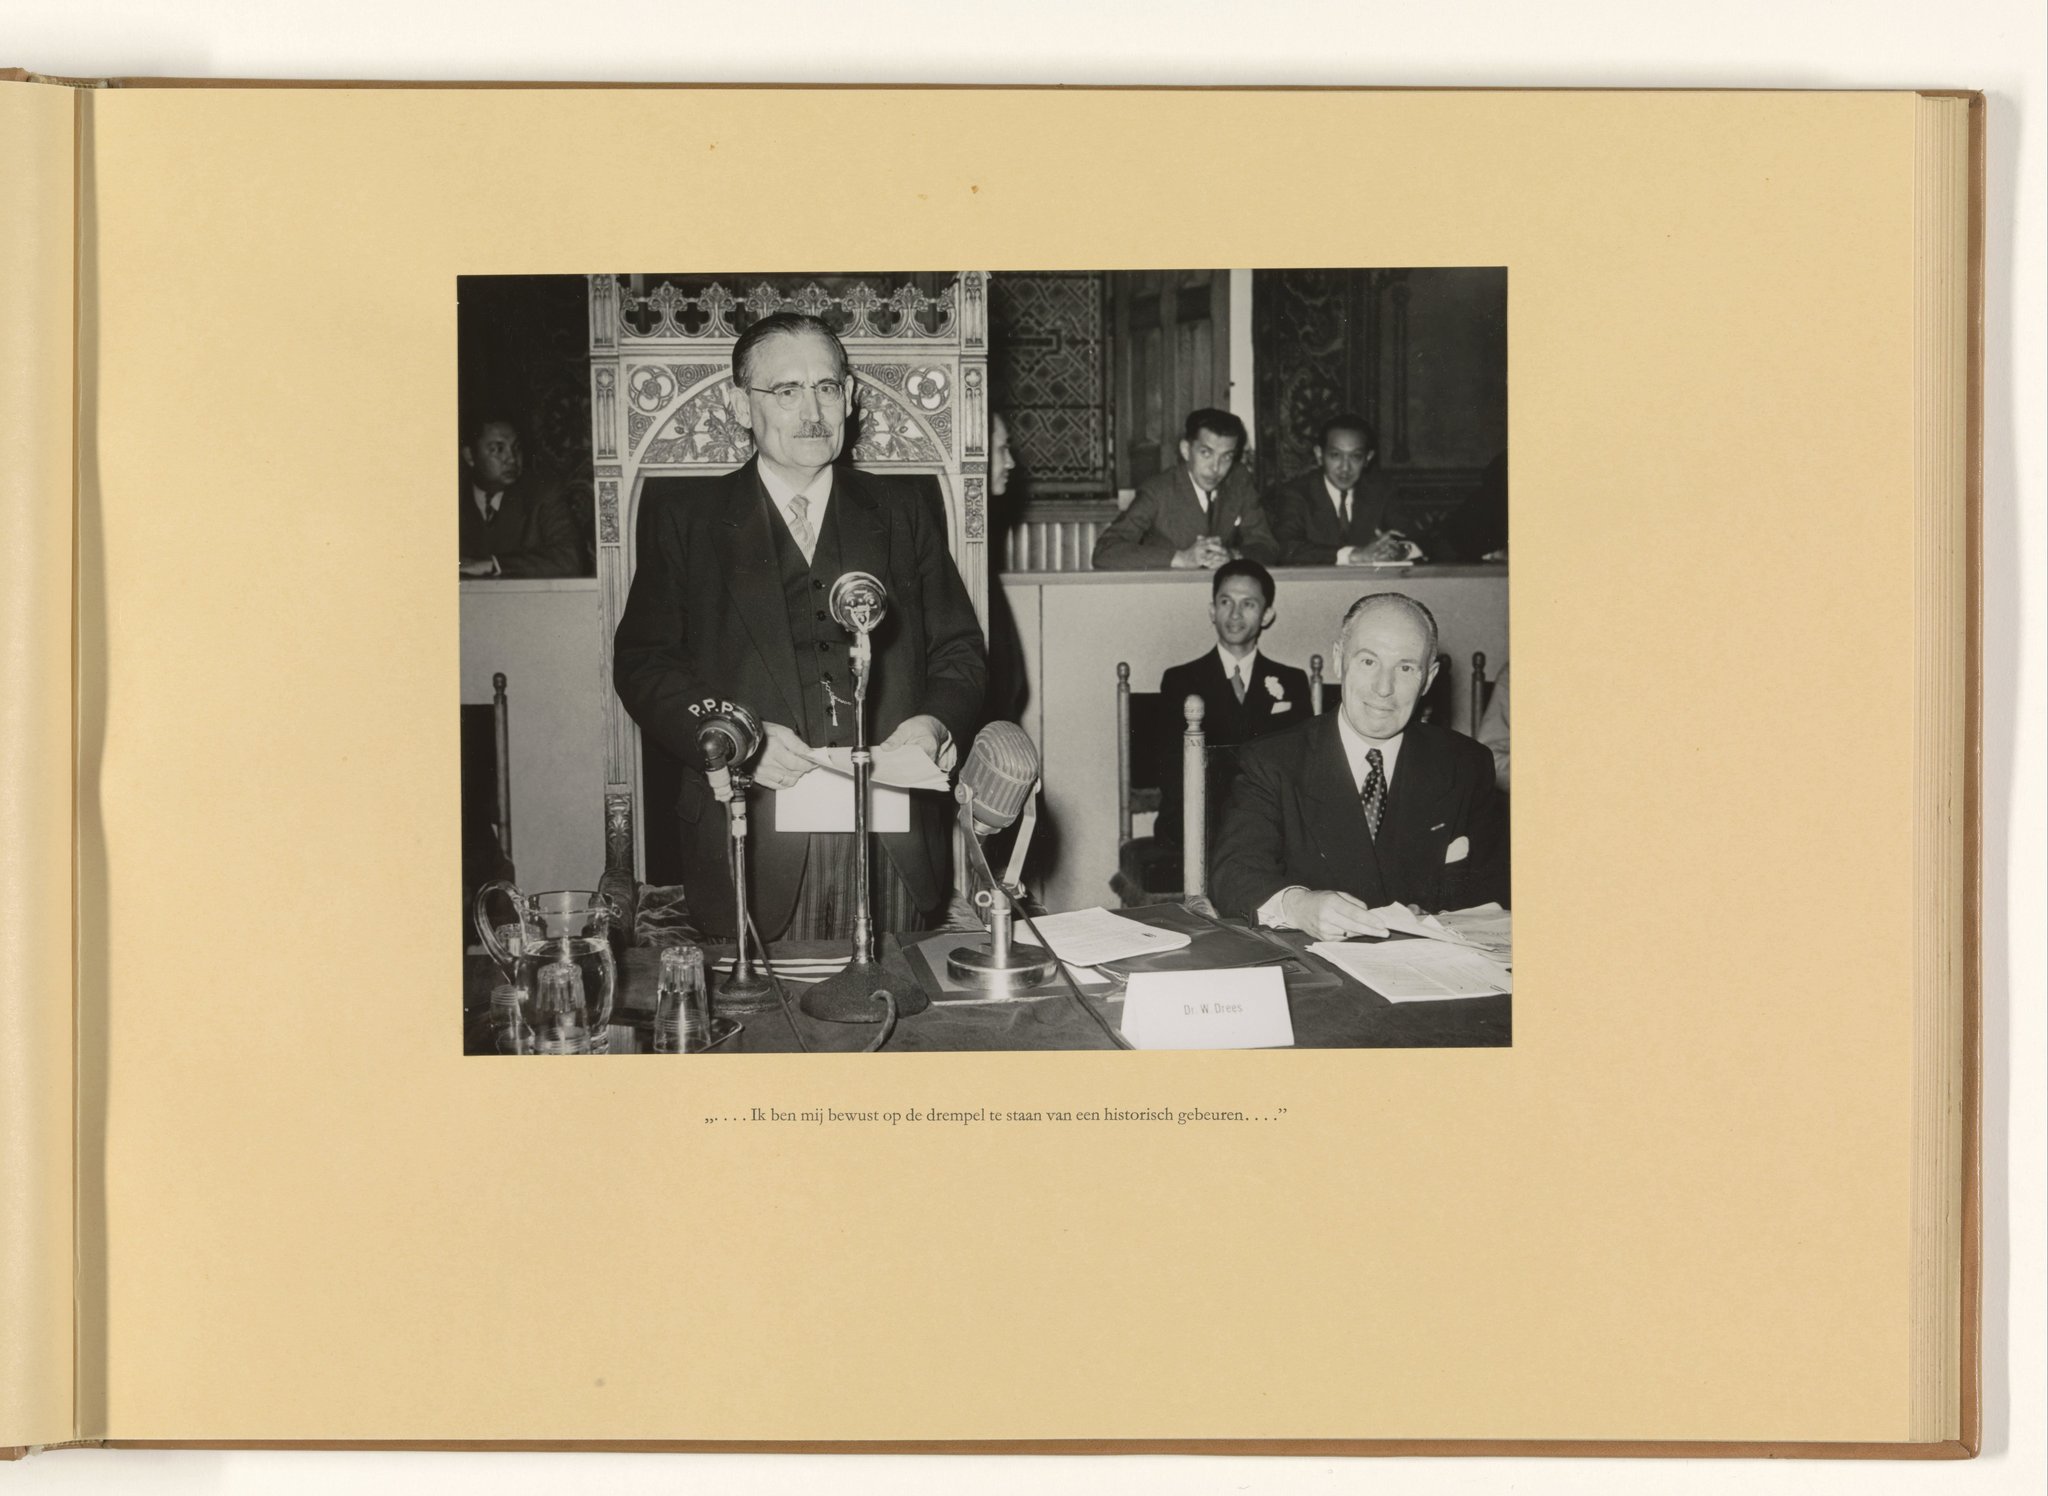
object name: photograph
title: " .... Ik ben mij bewust op de drempel te staan van een historisch gebeuren .... "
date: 1949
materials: paper, photographic support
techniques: gelatin silver print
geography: the hague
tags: amsterdam, the hague, willem drees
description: Premier Willem Drees spreekt de aanwezigen toe op de openingszitting van de conferentie in de Ridderzaal op 23 augustus. Foto in het fotoalbum met 37 foto's van de rondetafelconferentie gehouden tussen 23 augustus en 2 november in Den Haag in 1949 tussen vertegenwoordigers van Nederland, de Republiek Indonesië en de Bijeenkomst Federaal Overleg. Het exemplaar aangeboden aan premier Willem Drees.